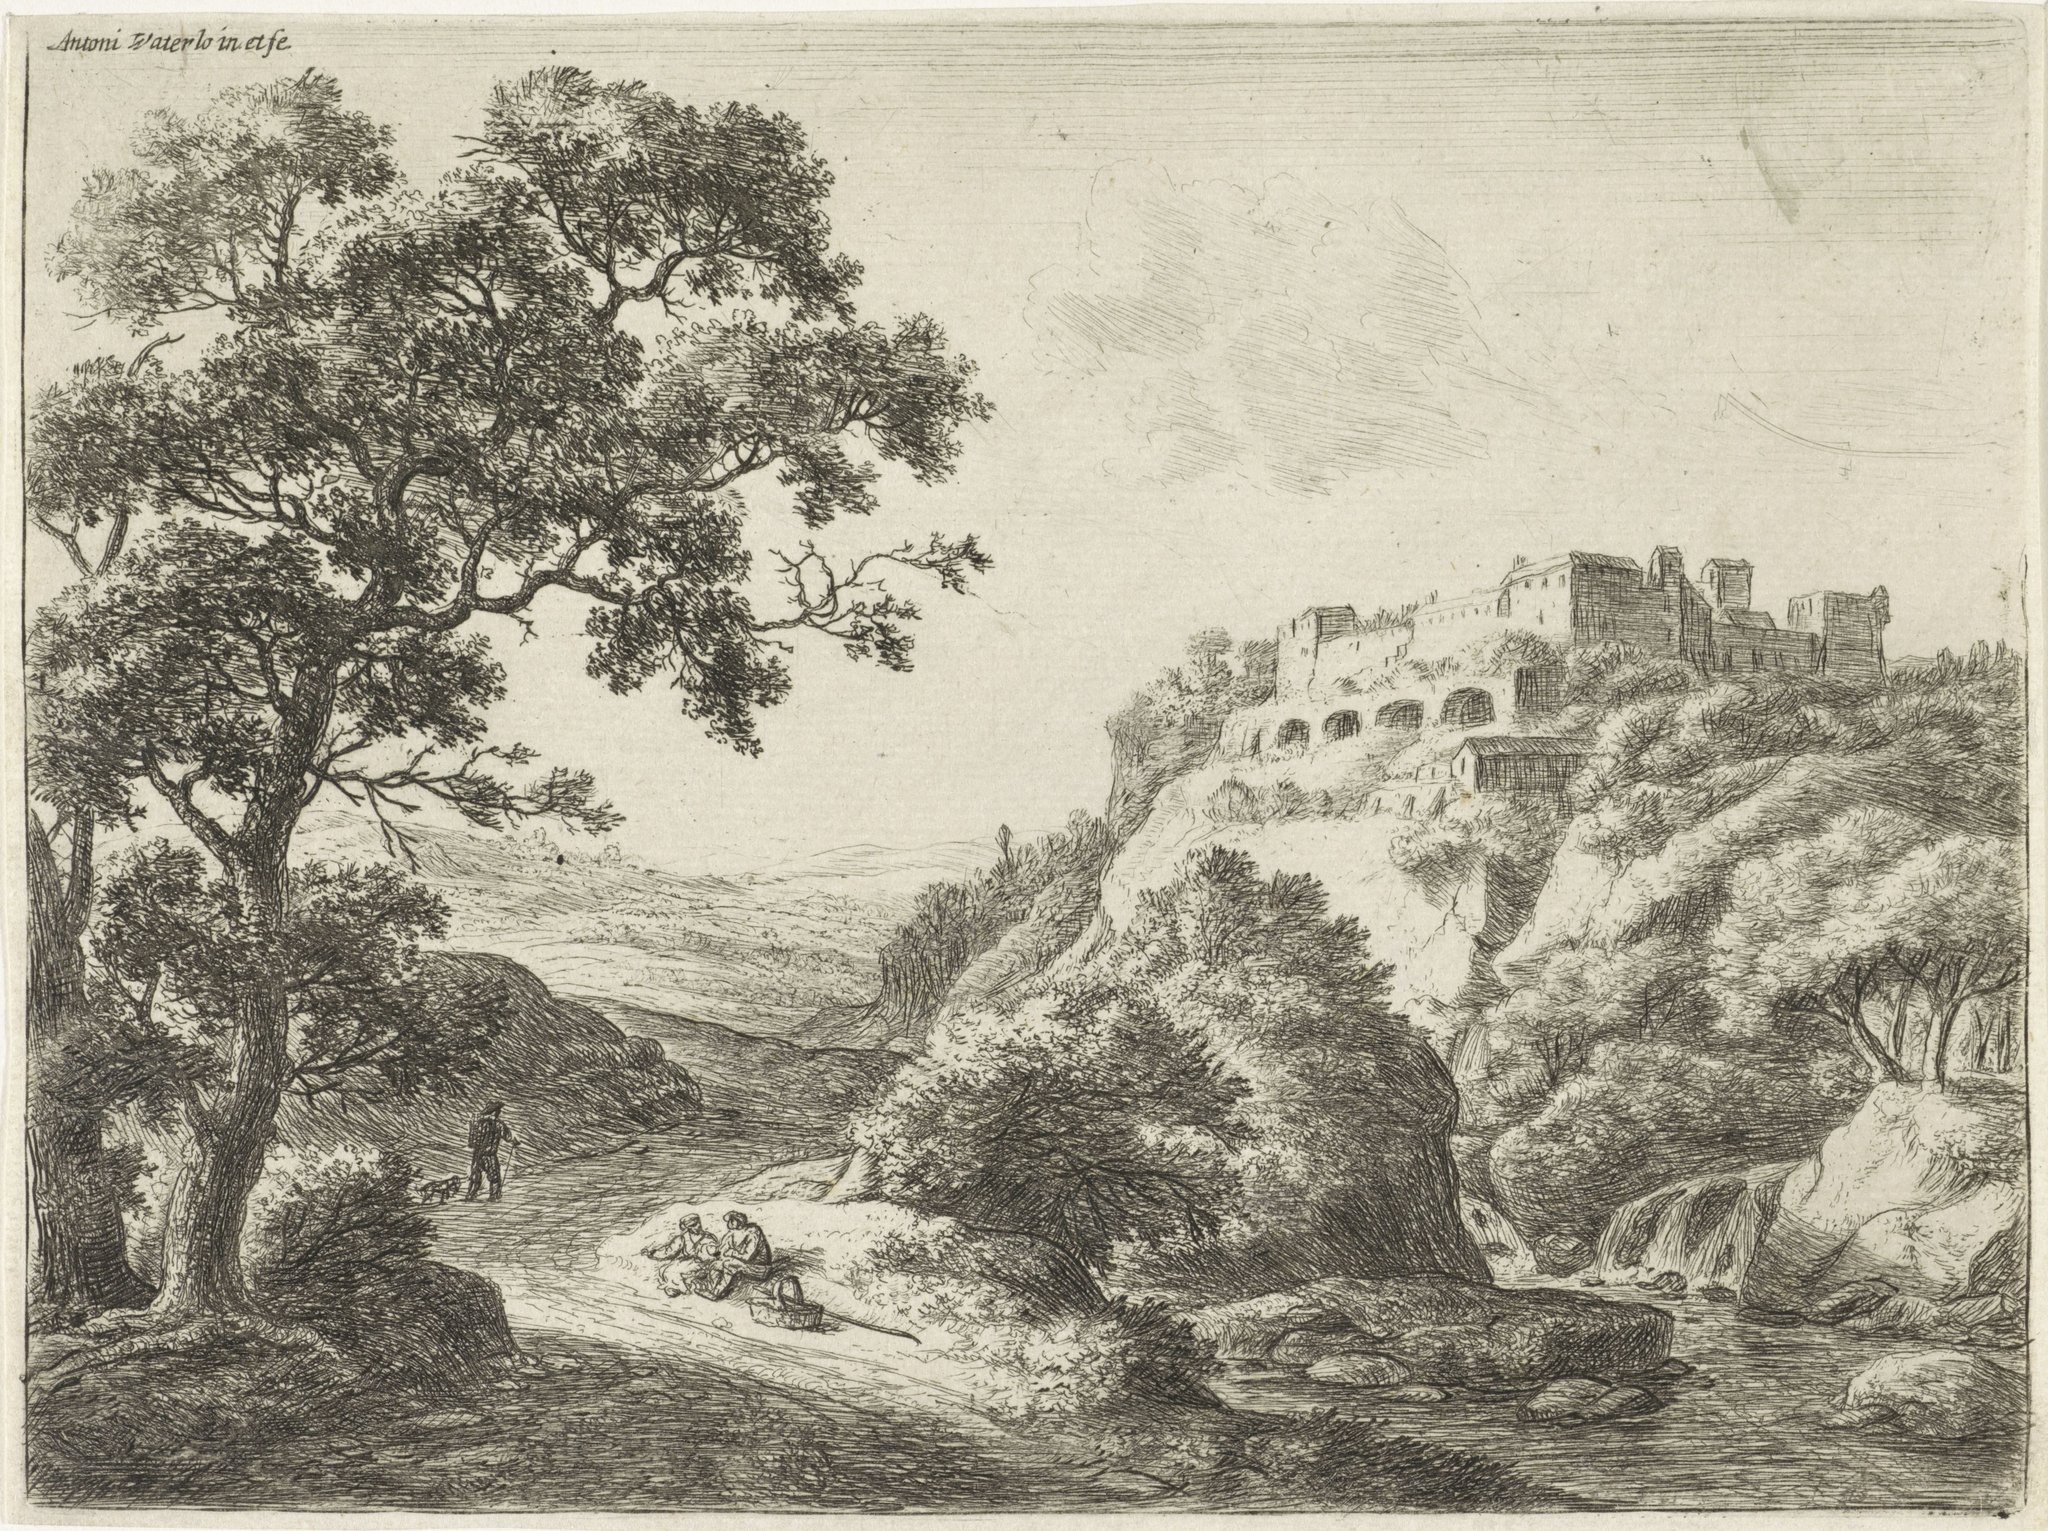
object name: print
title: Landschappen, serie A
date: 1630-1663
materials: paper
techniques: etching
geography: amsterdam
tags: low hill country, castle, road, path, brook, 'en route', traveller under way, resting - bb - out of doors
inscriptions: collector's mark: Lugt 2228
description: Rechts ligt een burcht op een heuvel. Aan de voet van de heuvel stroomt een beek. Links is een landweg met een man en een hond weergegeven. Langs het pad zitten twee rustende reizigers bij een mand.